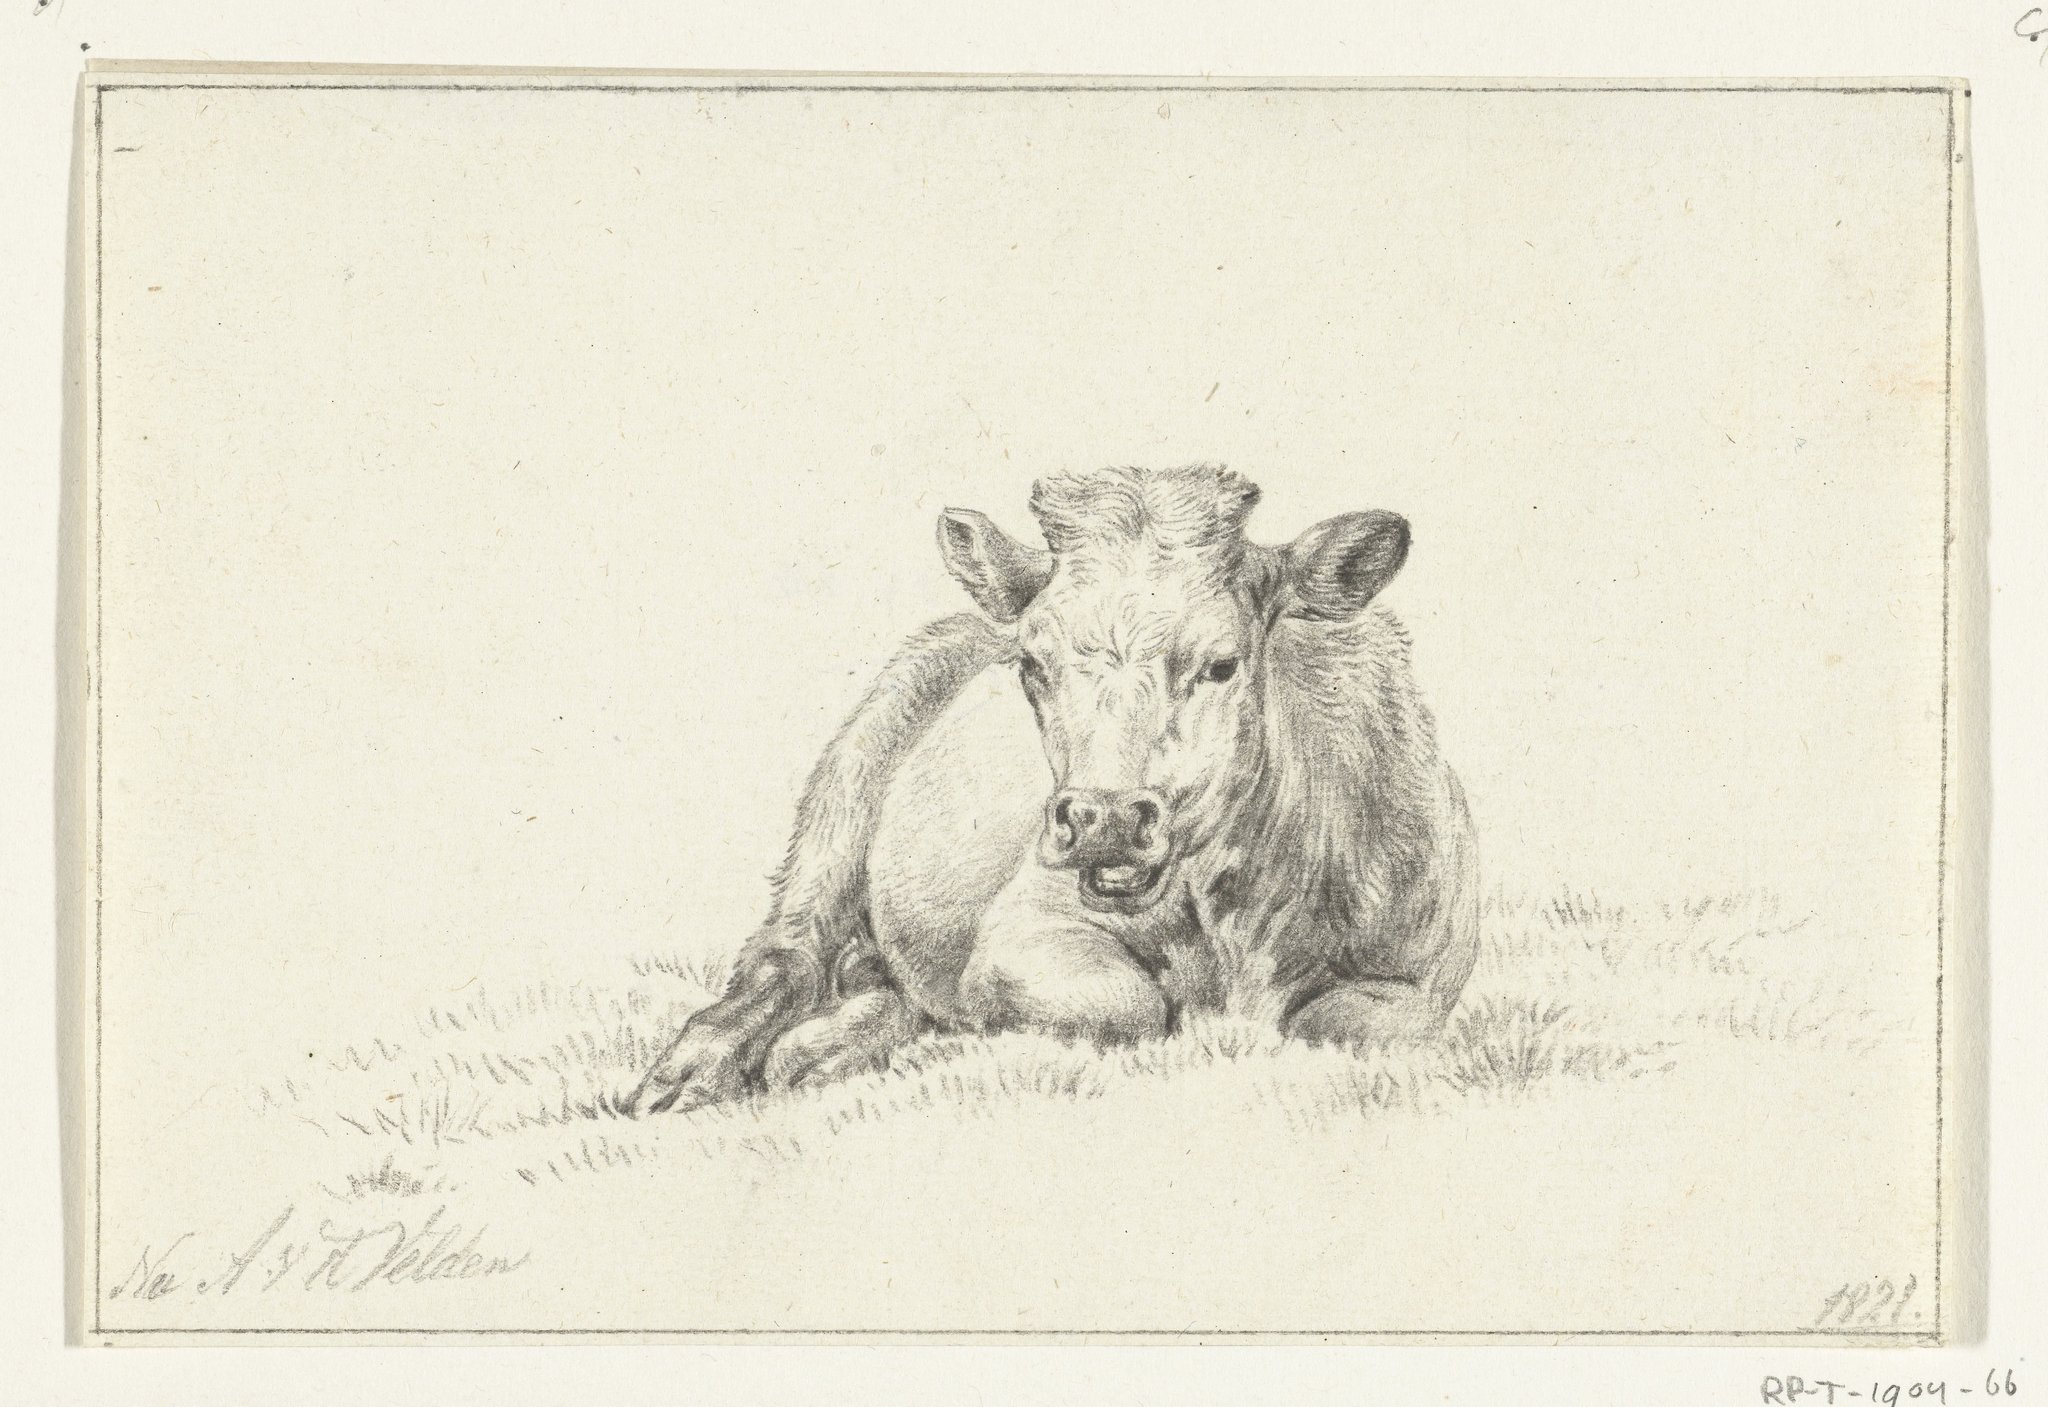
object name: drawing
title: Liggende koe, van voren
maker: jean bernard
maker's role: draughtsman, print maker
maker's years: 1765-1833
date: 1821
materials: chalk, paper, pencil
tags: cow